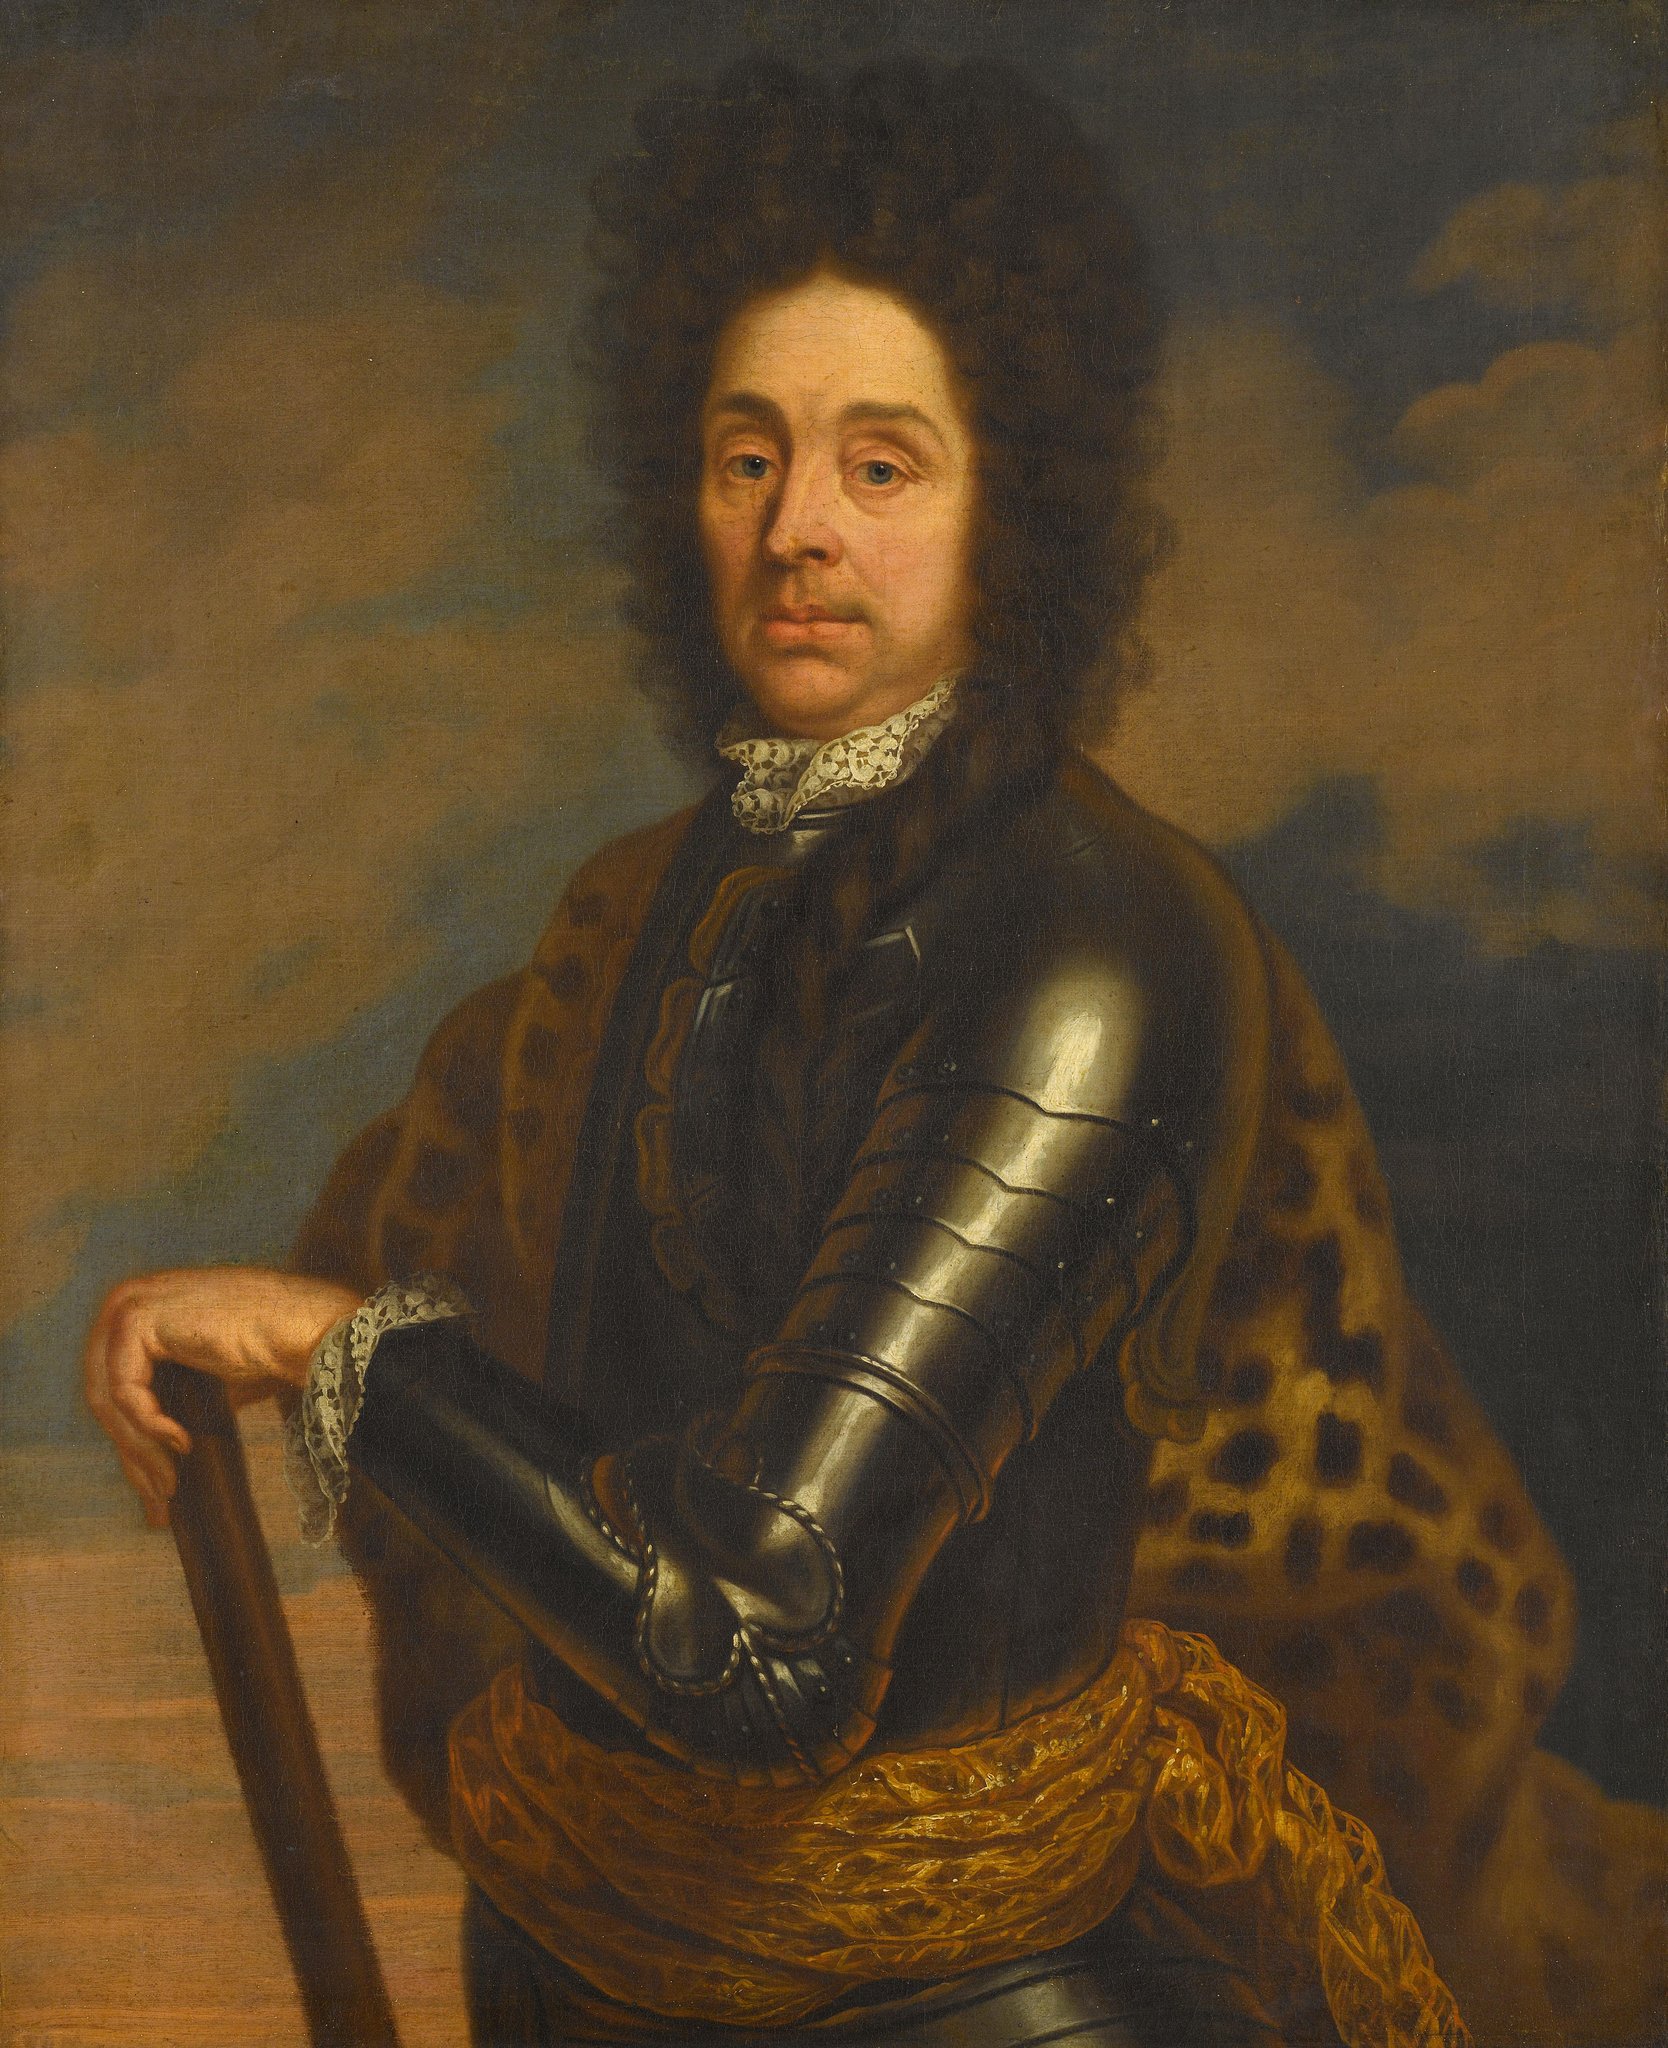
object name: painting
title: Portrait of Menno Baron van Coehoorn (1641-1704). General in the Artillery and Fortifications Engineer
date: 1675-1700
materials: canvas, oil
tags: commander-in-chief, general, marshal, historical persons, portrait, self-portrait of architect, fortifications, military engineering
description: Menno van Coehoorn, copy after Caspar Netscher. After the disasters of 1672 more attention was paid to the nation's defences. Baron Menno van Coehoorn (1641-1702) enjoyed an international reputation as an expert on fortifications. He received an academic education in mathematics and fortifications, then a subject taught at universities. In the late 17th century Menno van Coehoorn began work on a defensive line designed to keep the enemy in check the Republic's frontiers.